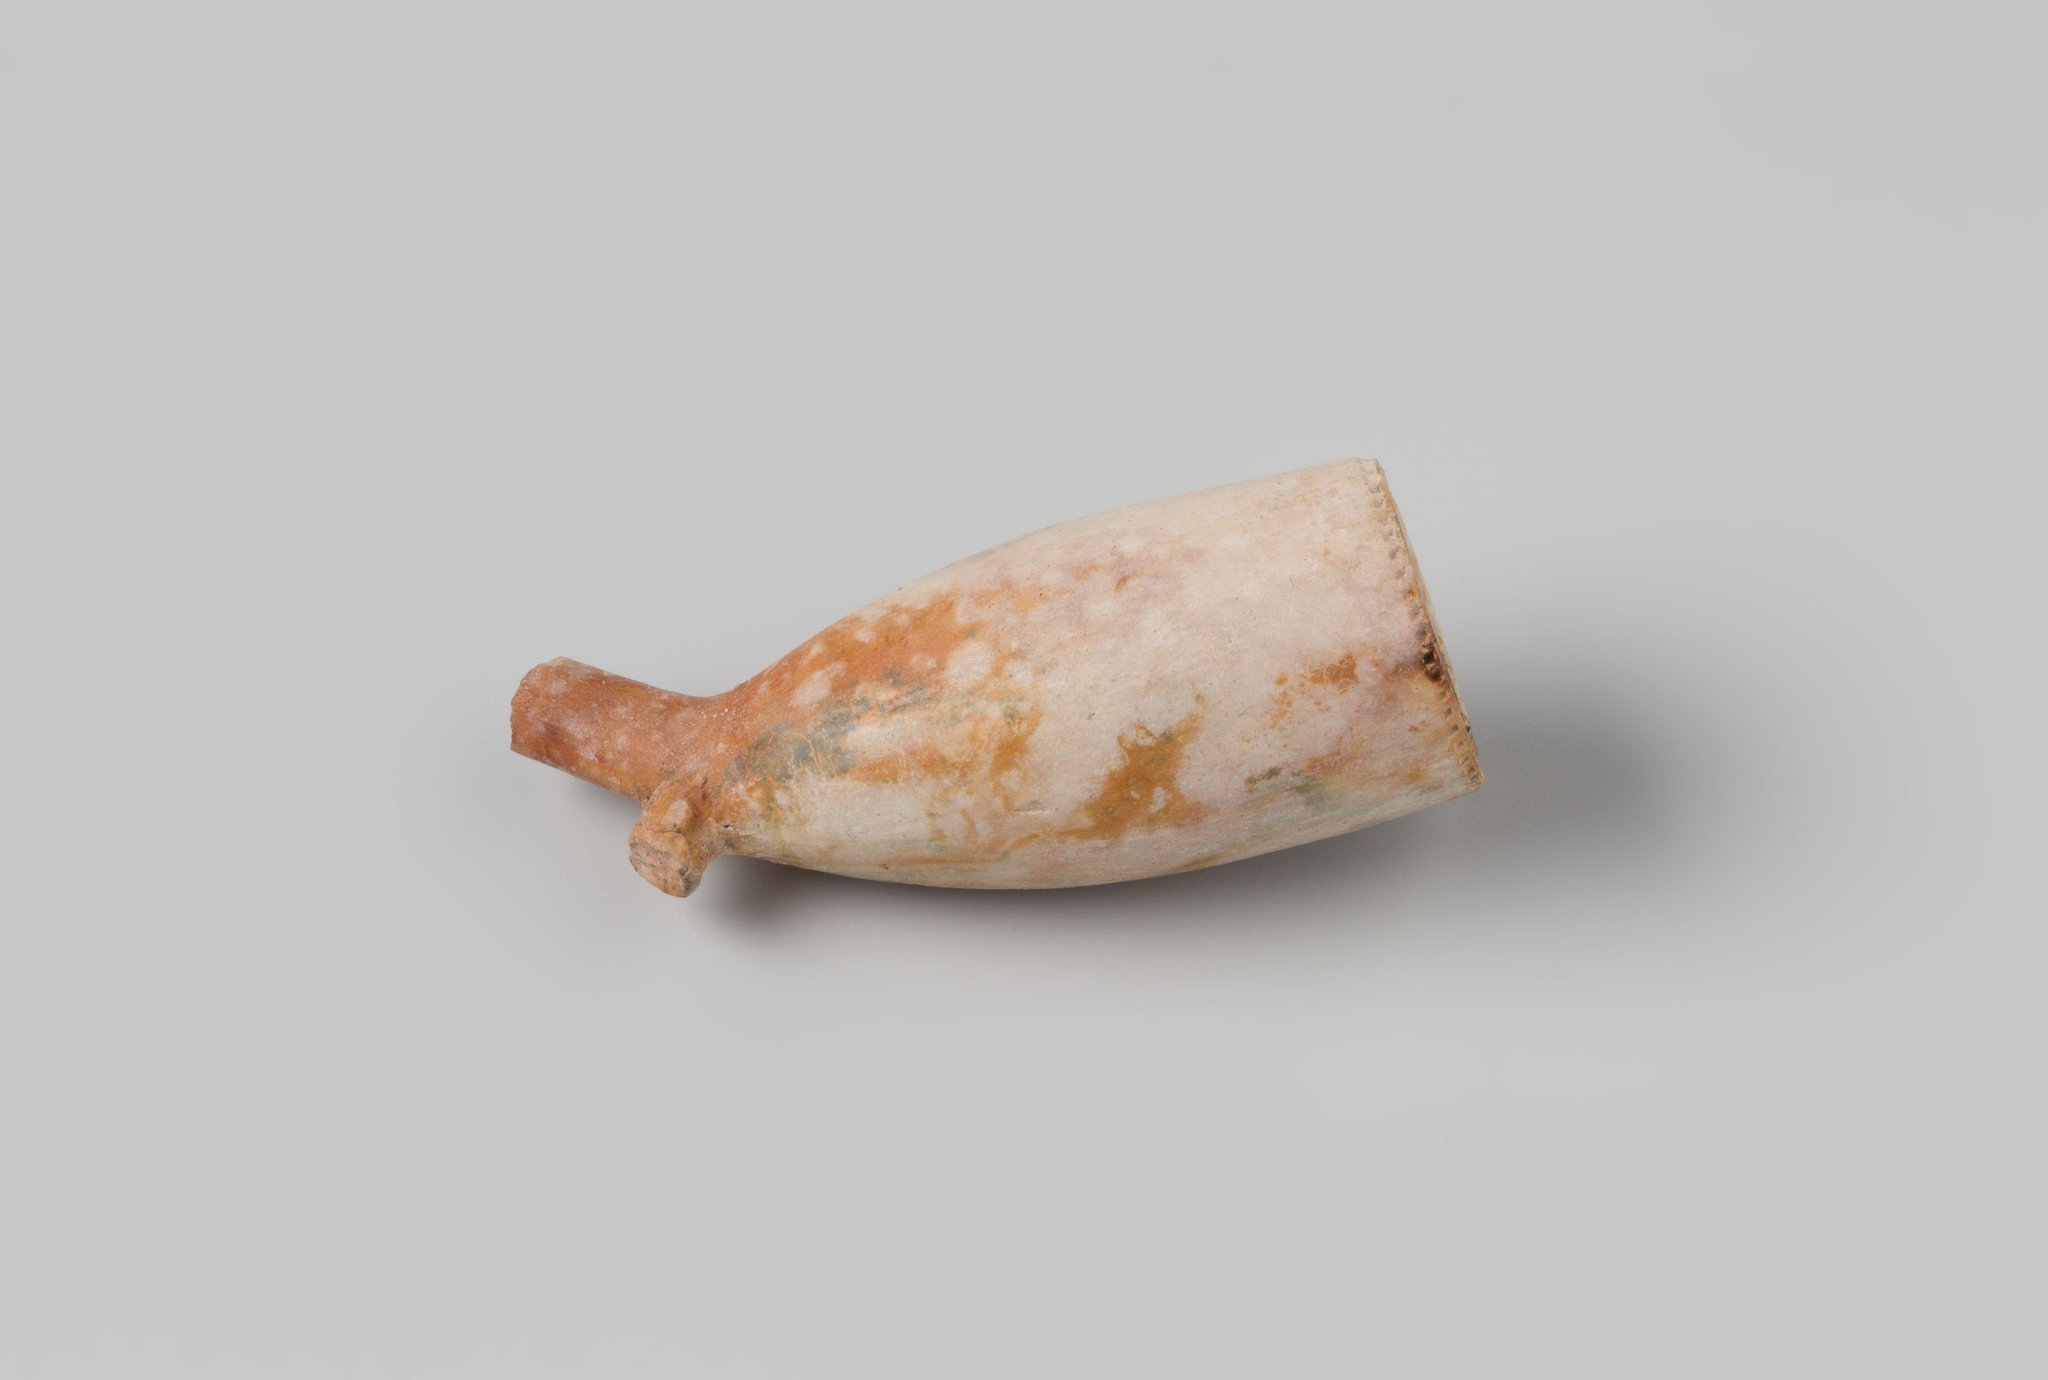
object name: pipe bowl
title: Pijpenkop uit het wrak van de Oost-Indiëvaarder Hollandia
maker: Anonymous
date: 1700-1743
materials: clay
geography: netherlands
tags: verenigde oostindische compagnie, hollandia (schip), annet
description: Pipe, bowl, heelmark: crowned 47; 2hsm1,2.